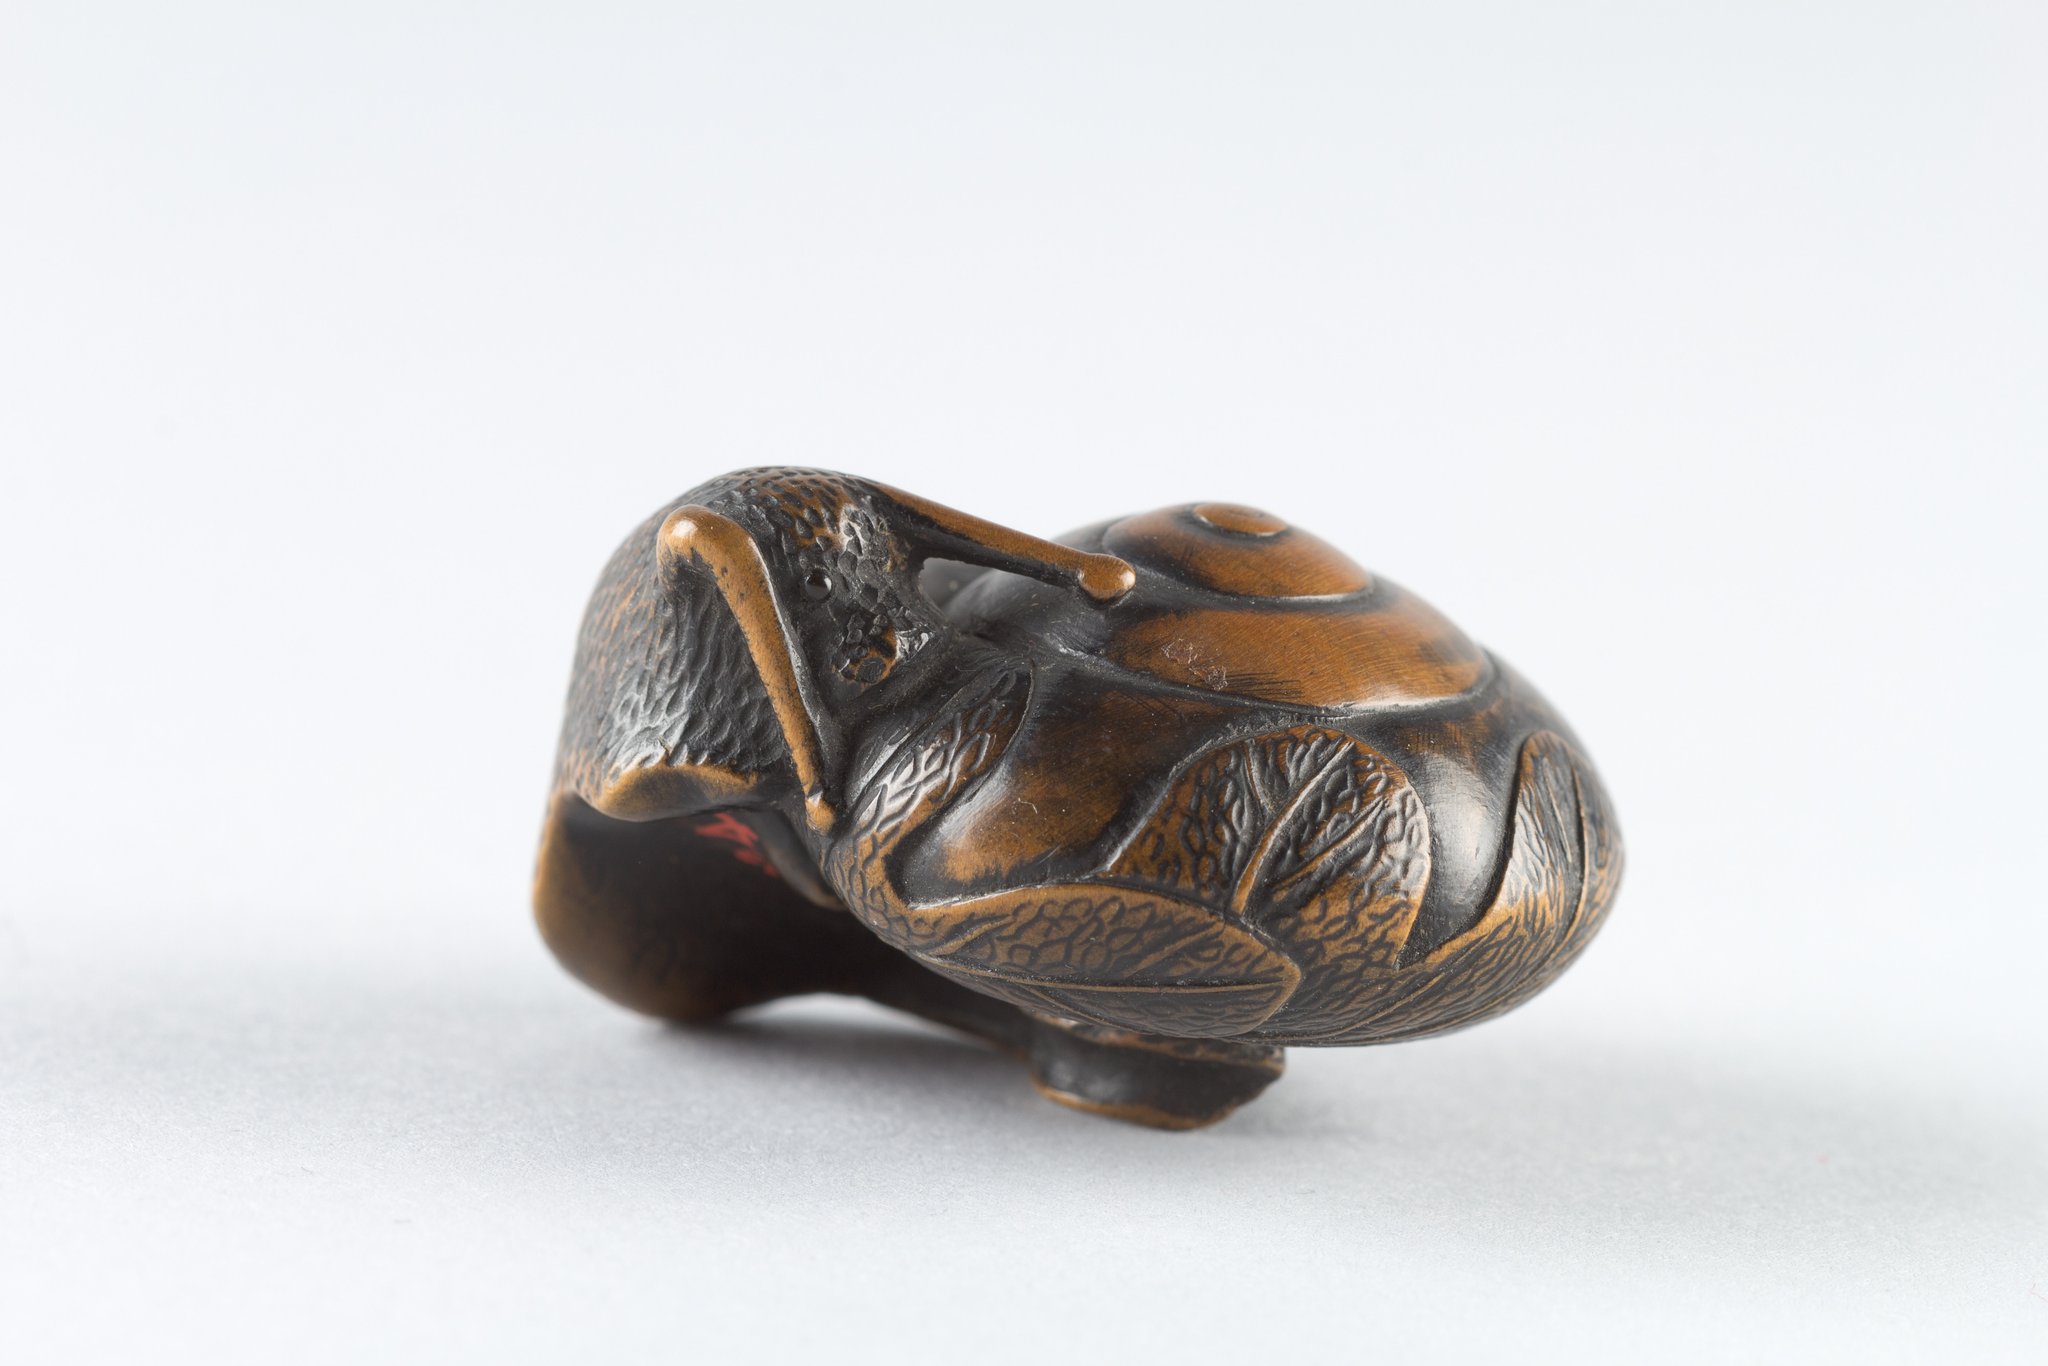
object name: netsuke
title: Netsuke of Snail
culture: japanese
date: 1801-1900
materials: wood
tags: snails